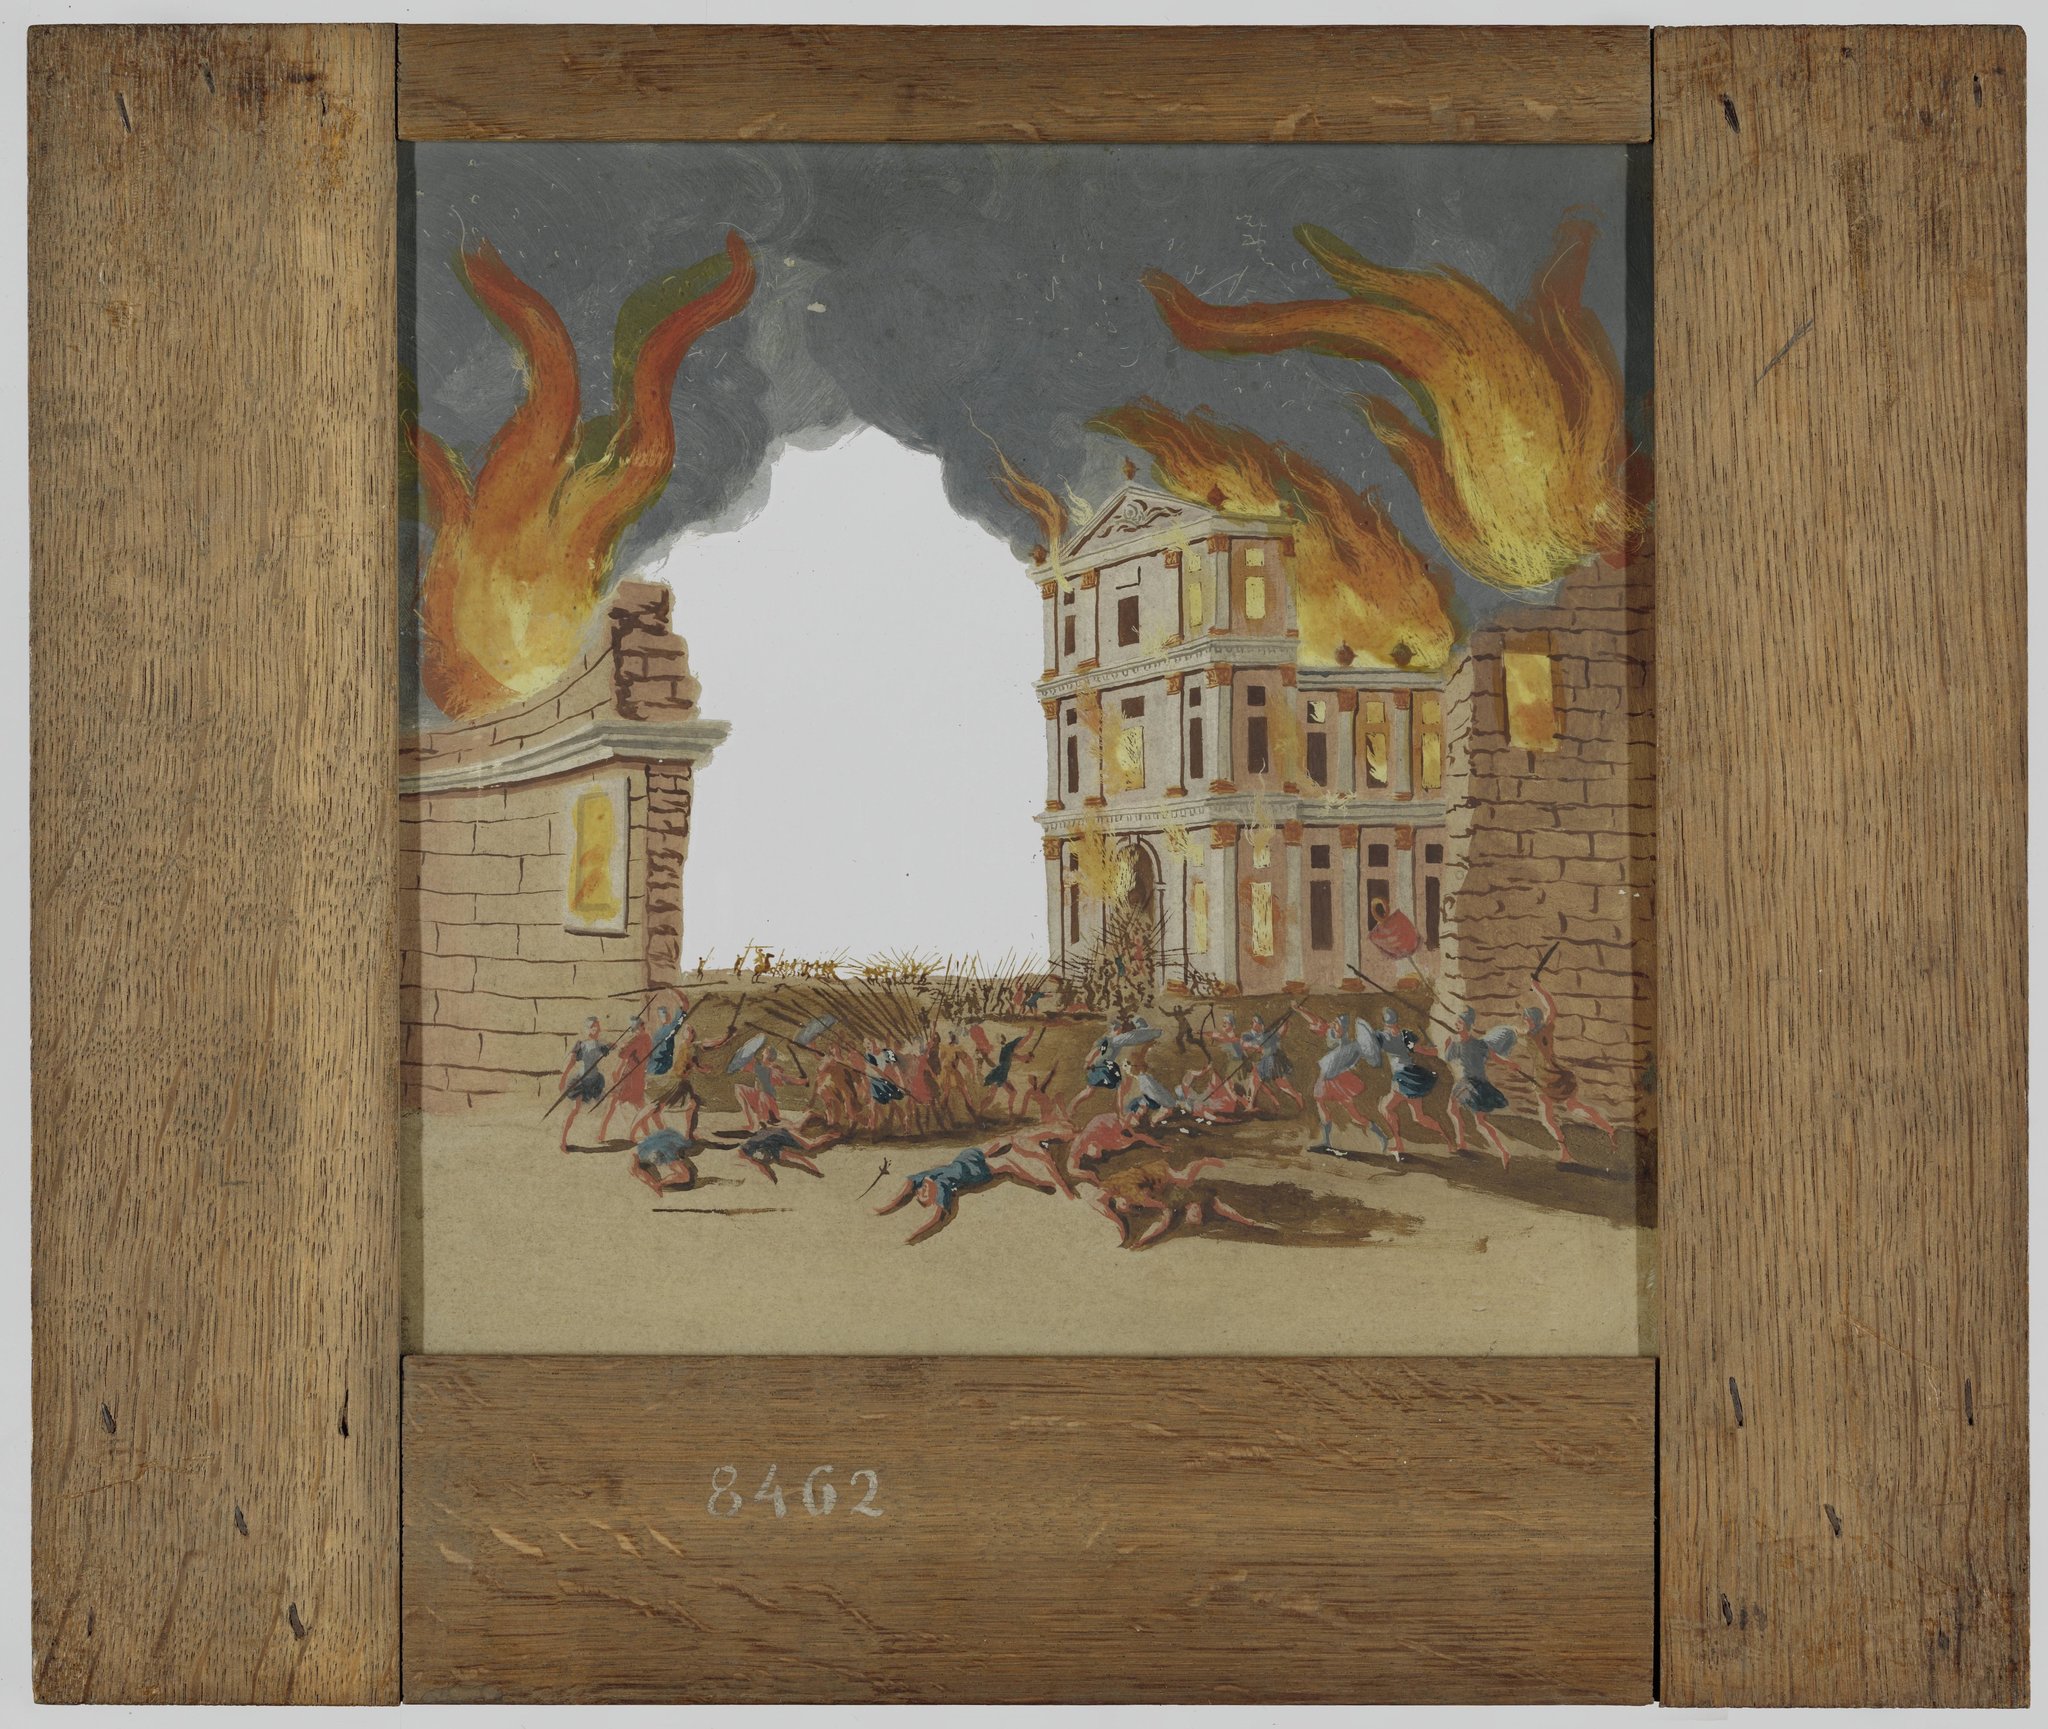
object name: diafanoramaplaat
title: Gevecht in een brandende stad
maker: Anonymous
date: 1750-1830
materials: glass, wood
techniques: painted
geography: netherlands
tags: on fire, ablaze, the soldier; the soldier's life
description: Tussen brandende klassieke gebouwen is een groot aantal soldaten in een gevecht verwikkeld. Links van het midden is een deel van de glasplaat onbeschilderd. Onderdeel van een serie platen die samen een diafanorama vormt van een gevecht in een stad in de Klassieke Oudheid.